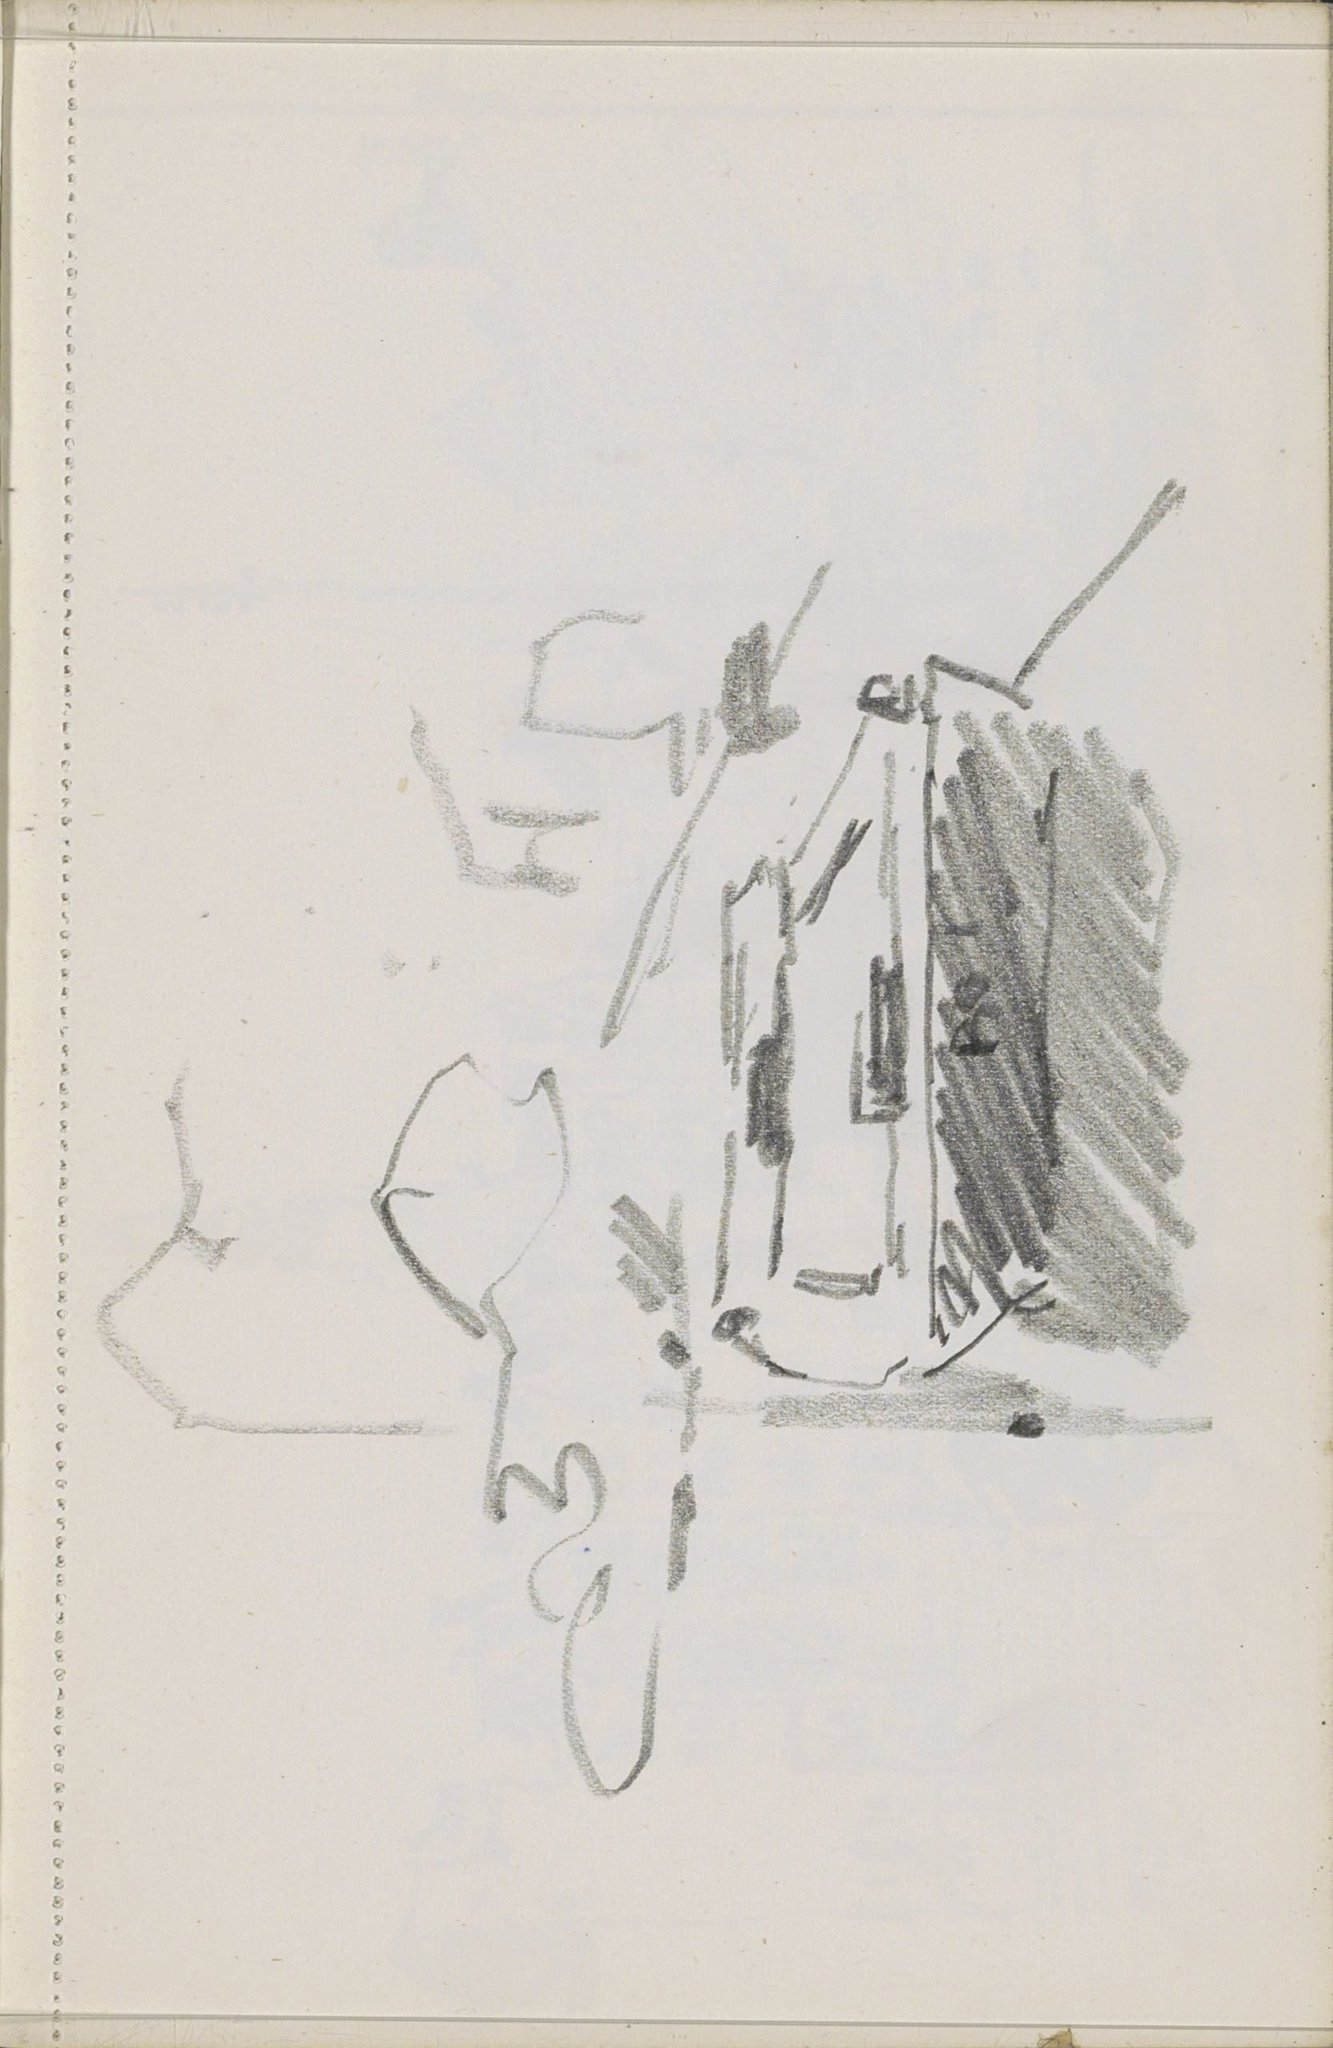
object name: sketchbook leaf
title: Studie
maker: cornelis vreedenburgh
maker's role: draughtsman, print maker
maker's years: 1880-1946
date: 1890-1946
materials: paper, pencil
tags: rowing-boat, canoe, etc.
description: Mogelijk een roeiboot. Blad 33 recto uit een schetsboek met 53 bladen.